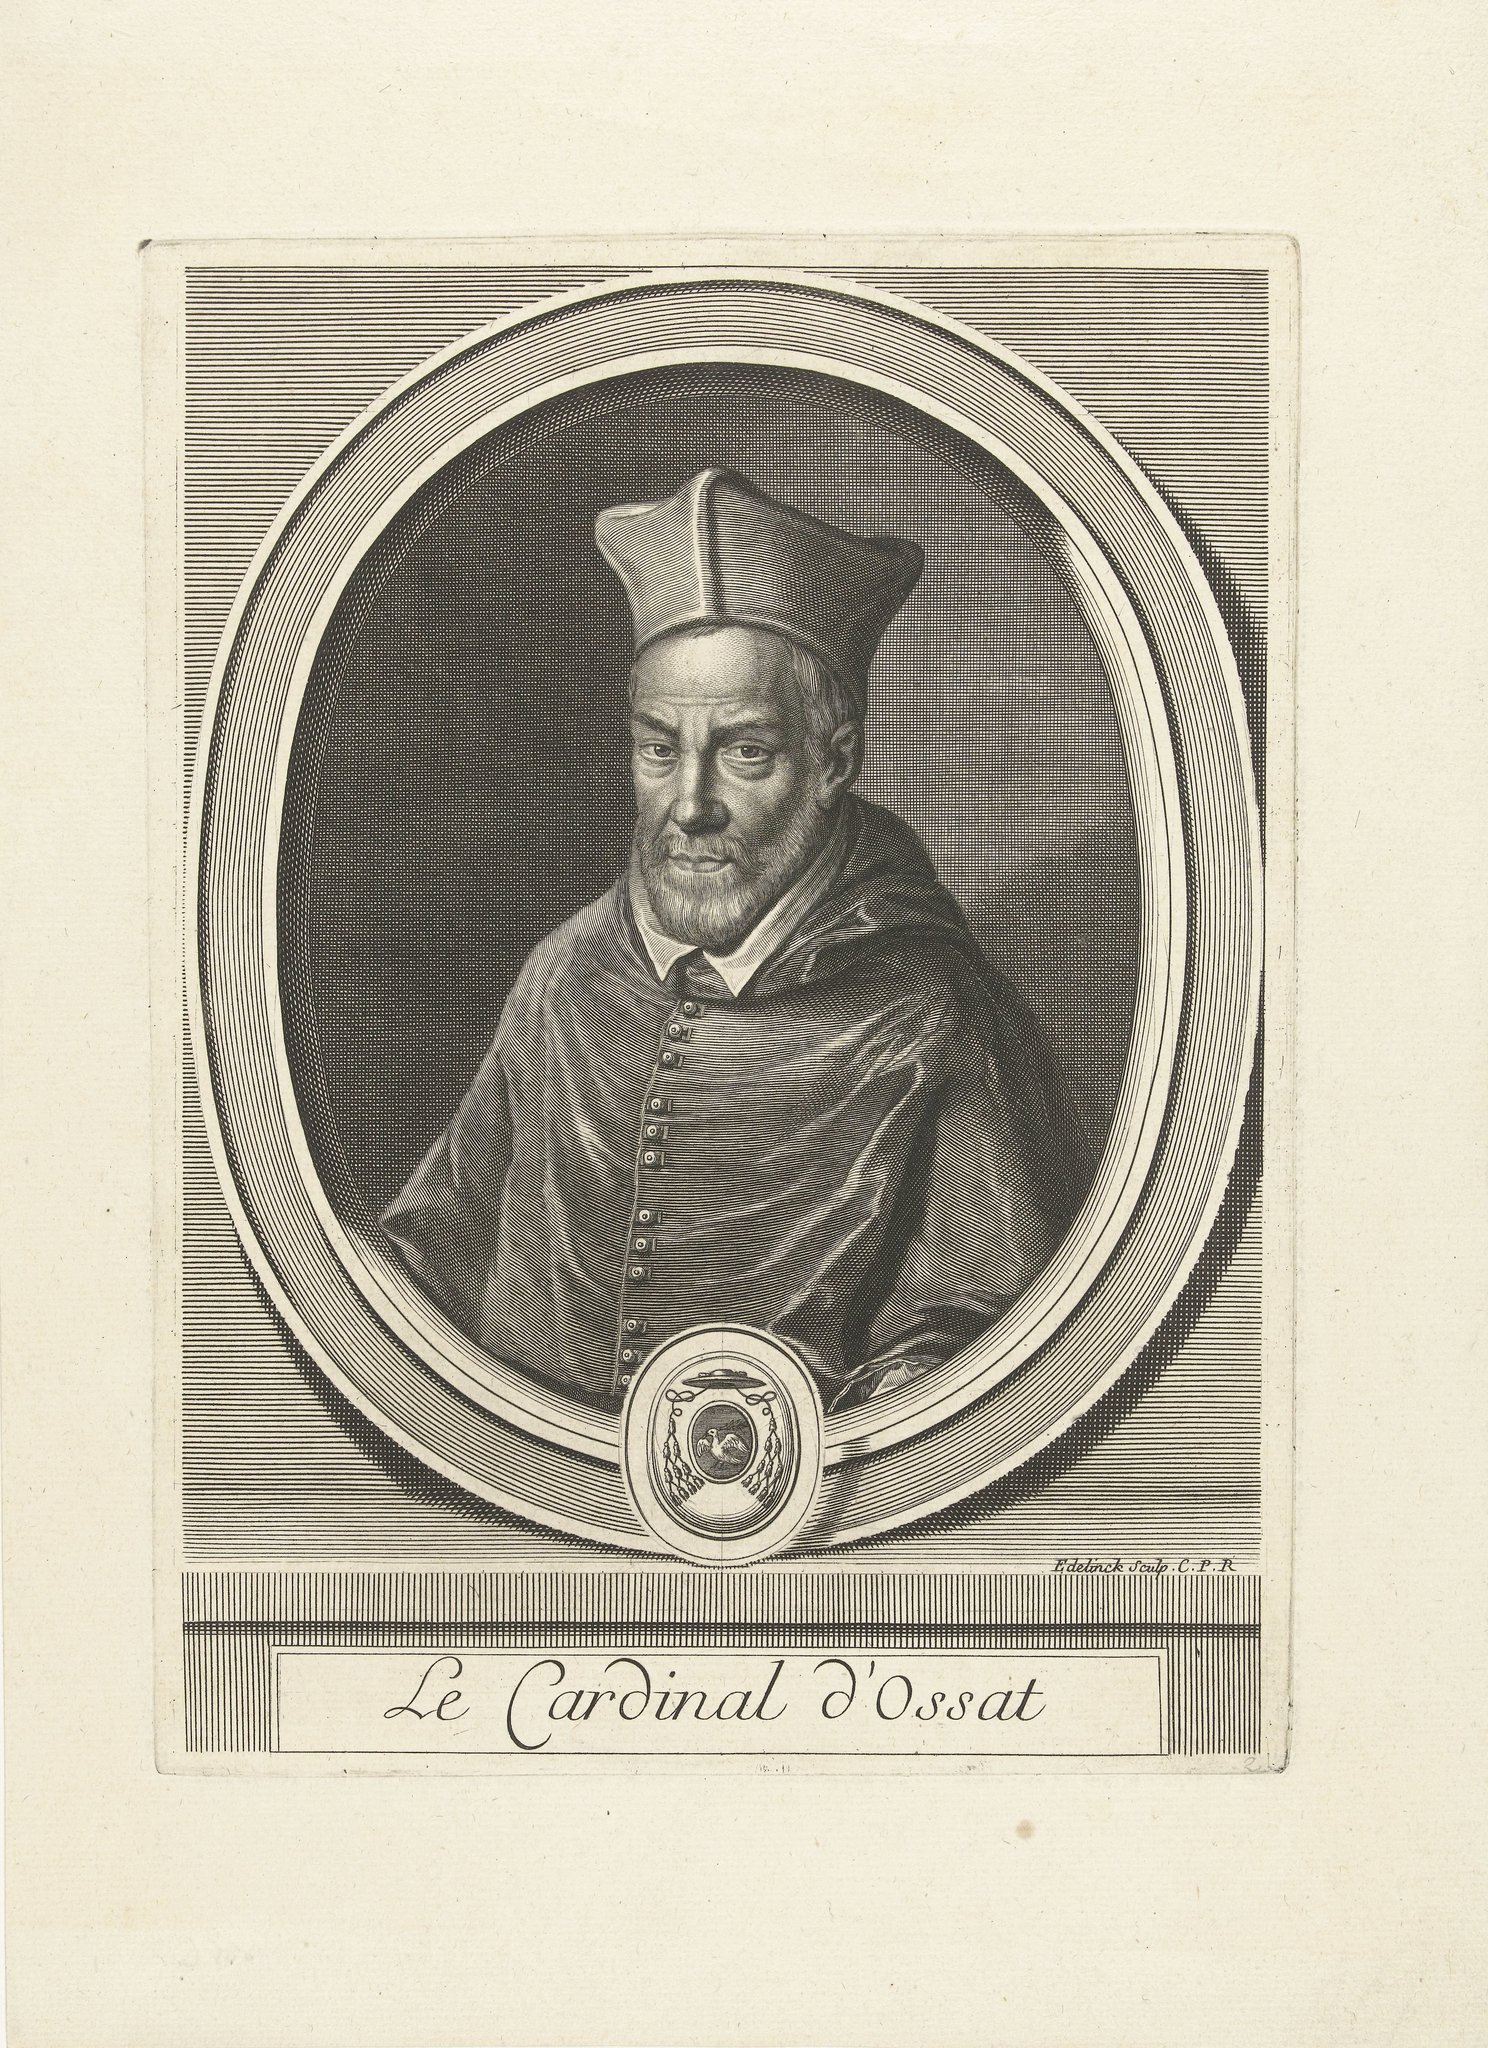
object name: print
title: Le Cardinal d'Ossat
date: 1666-1707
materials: paper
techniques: engraving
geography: france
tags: france, rome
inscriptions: collector's mark: Lugt 2228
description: Busteportret van kardinaal Arnaud d'Ossat (1537-1604), afgebeeld in ovale omlijsting met wapen.